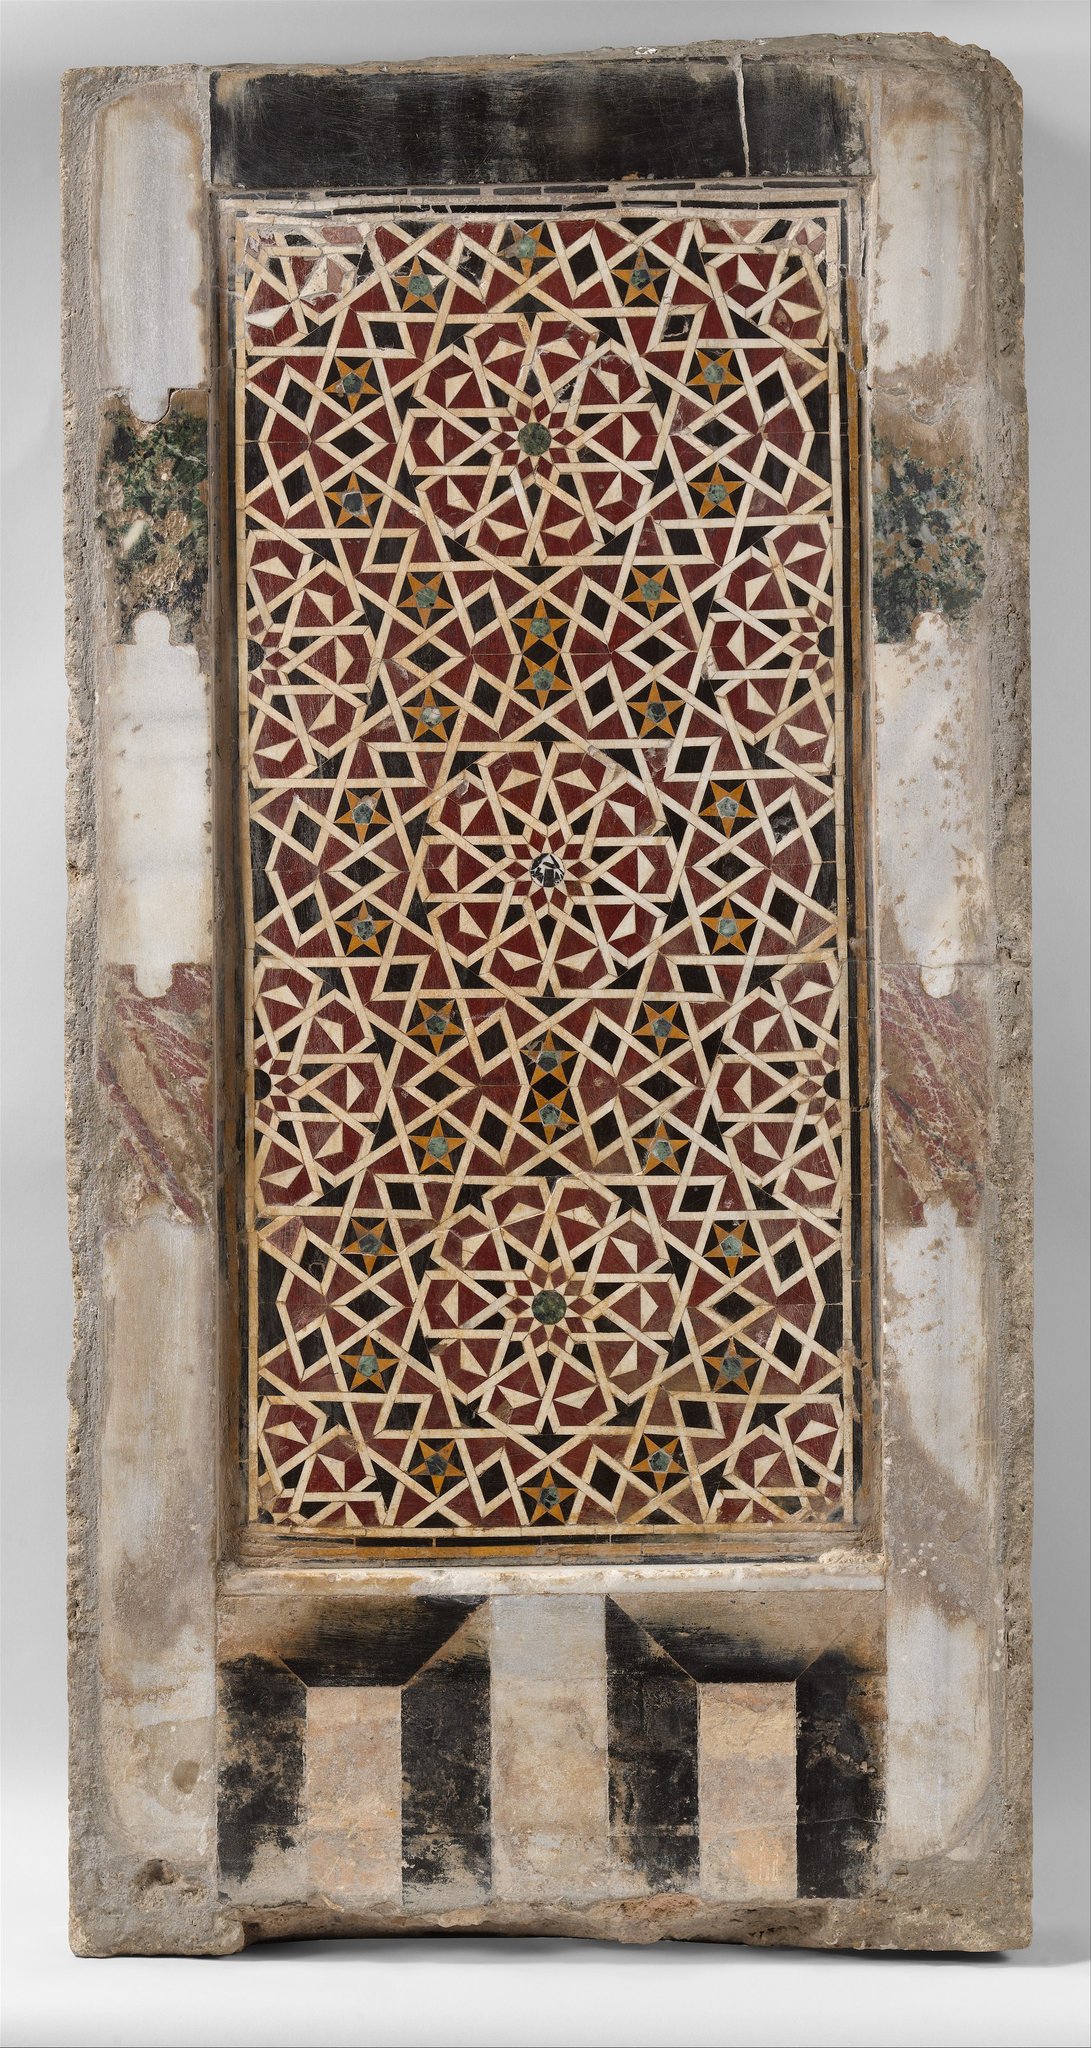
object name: panel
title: Wall Panel with Geometric Interlace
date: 1401-1500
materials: marble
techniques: polychrome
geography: egypt